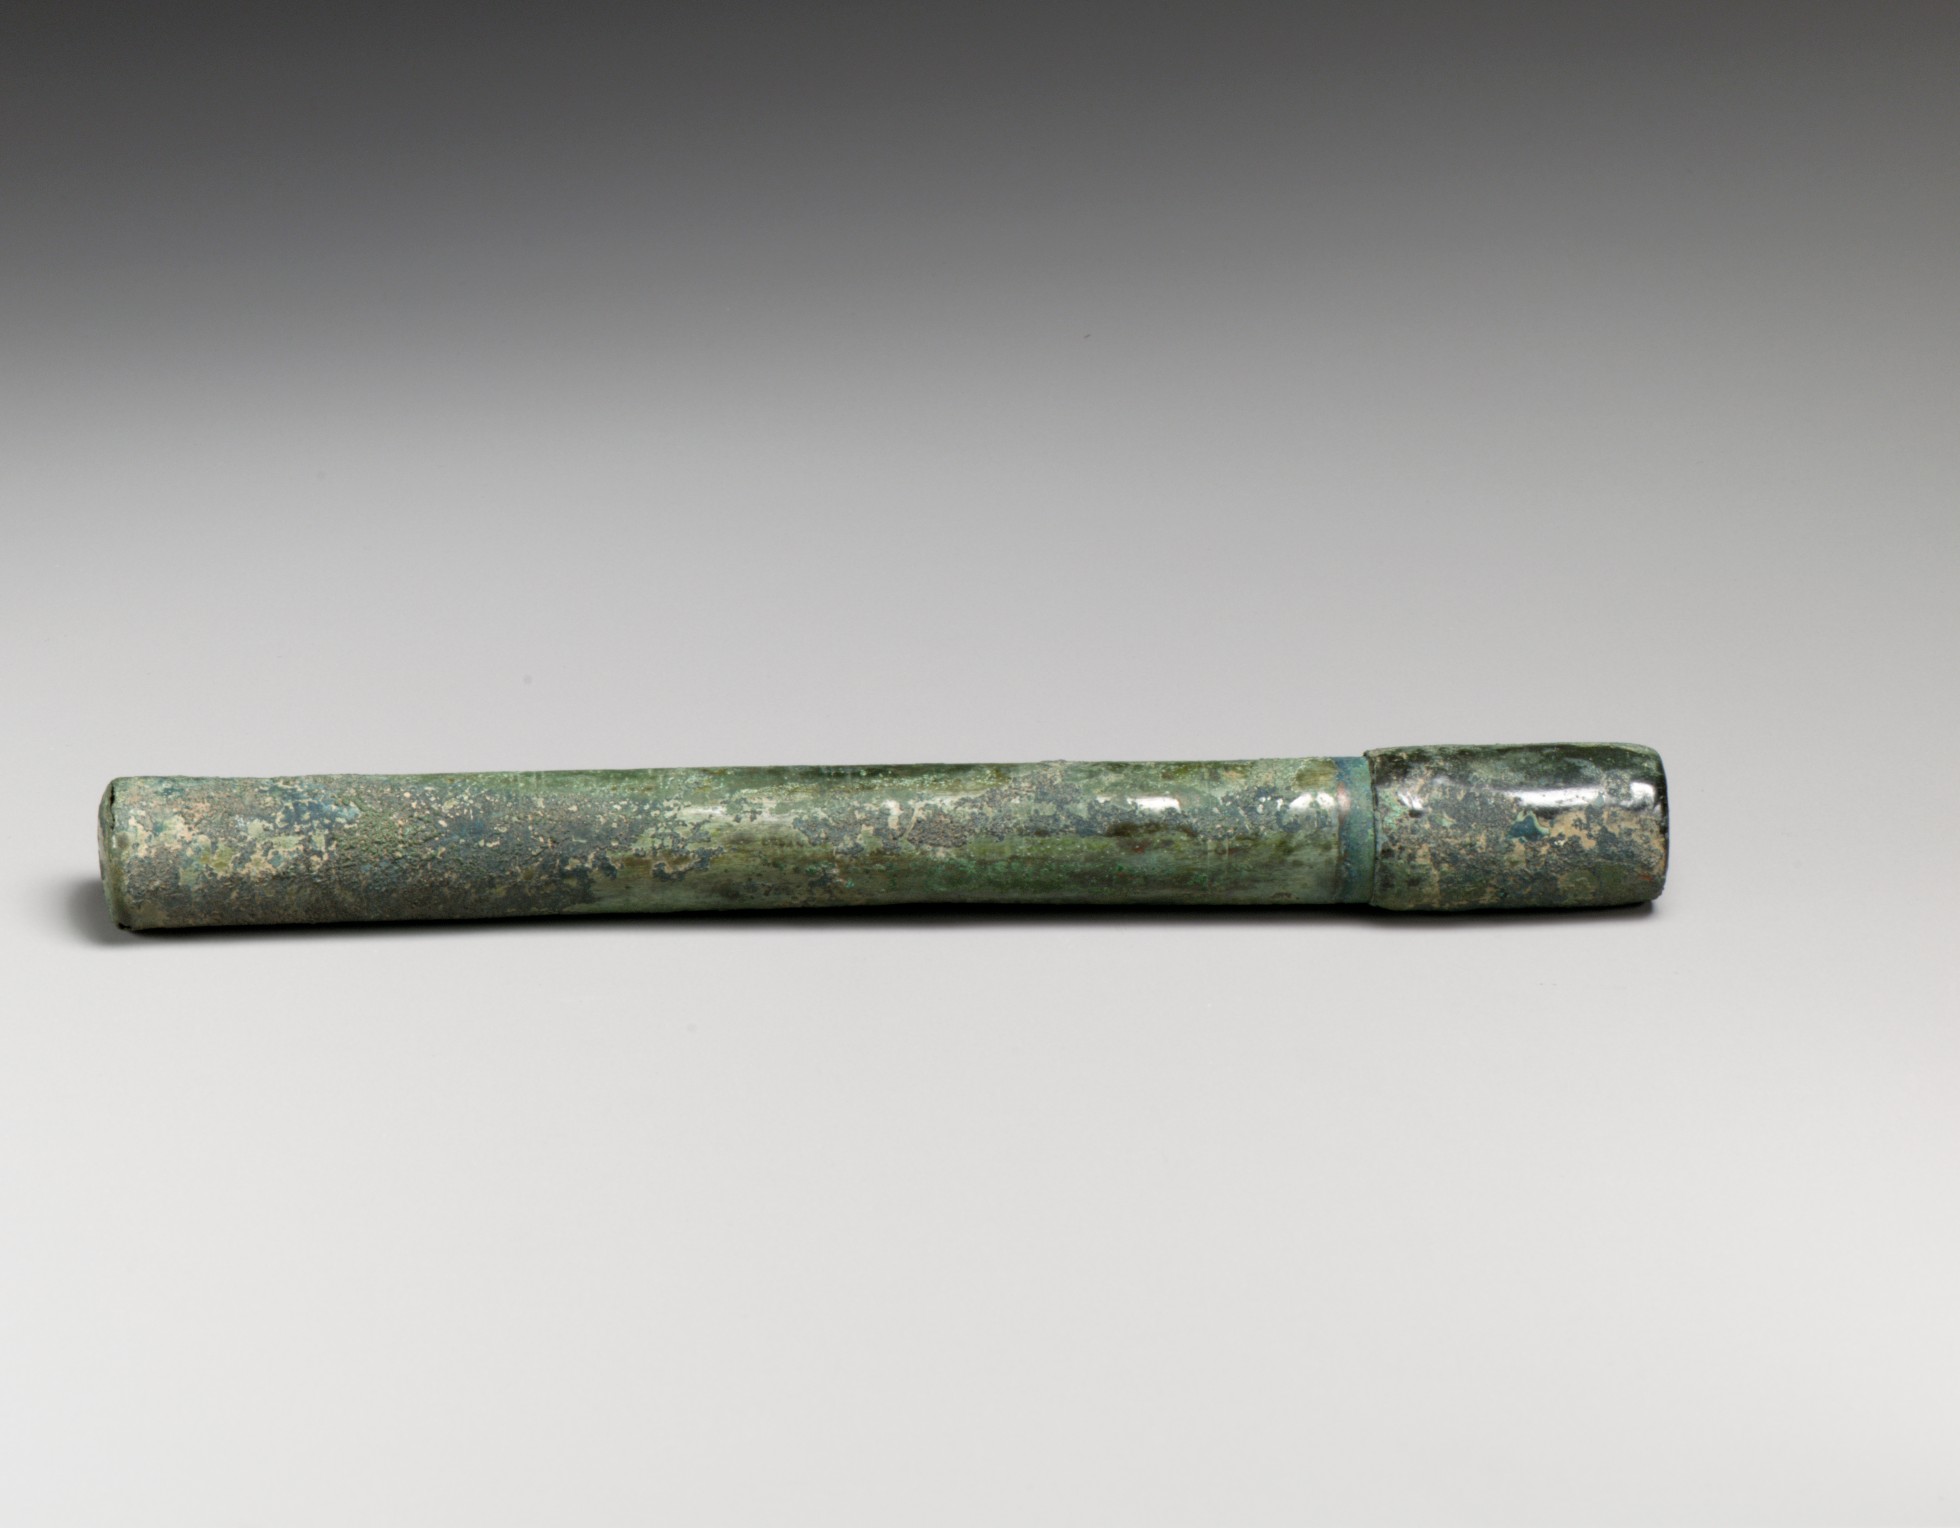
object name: cylinder box with lid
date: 7000 BCE-330 CE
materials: bronze